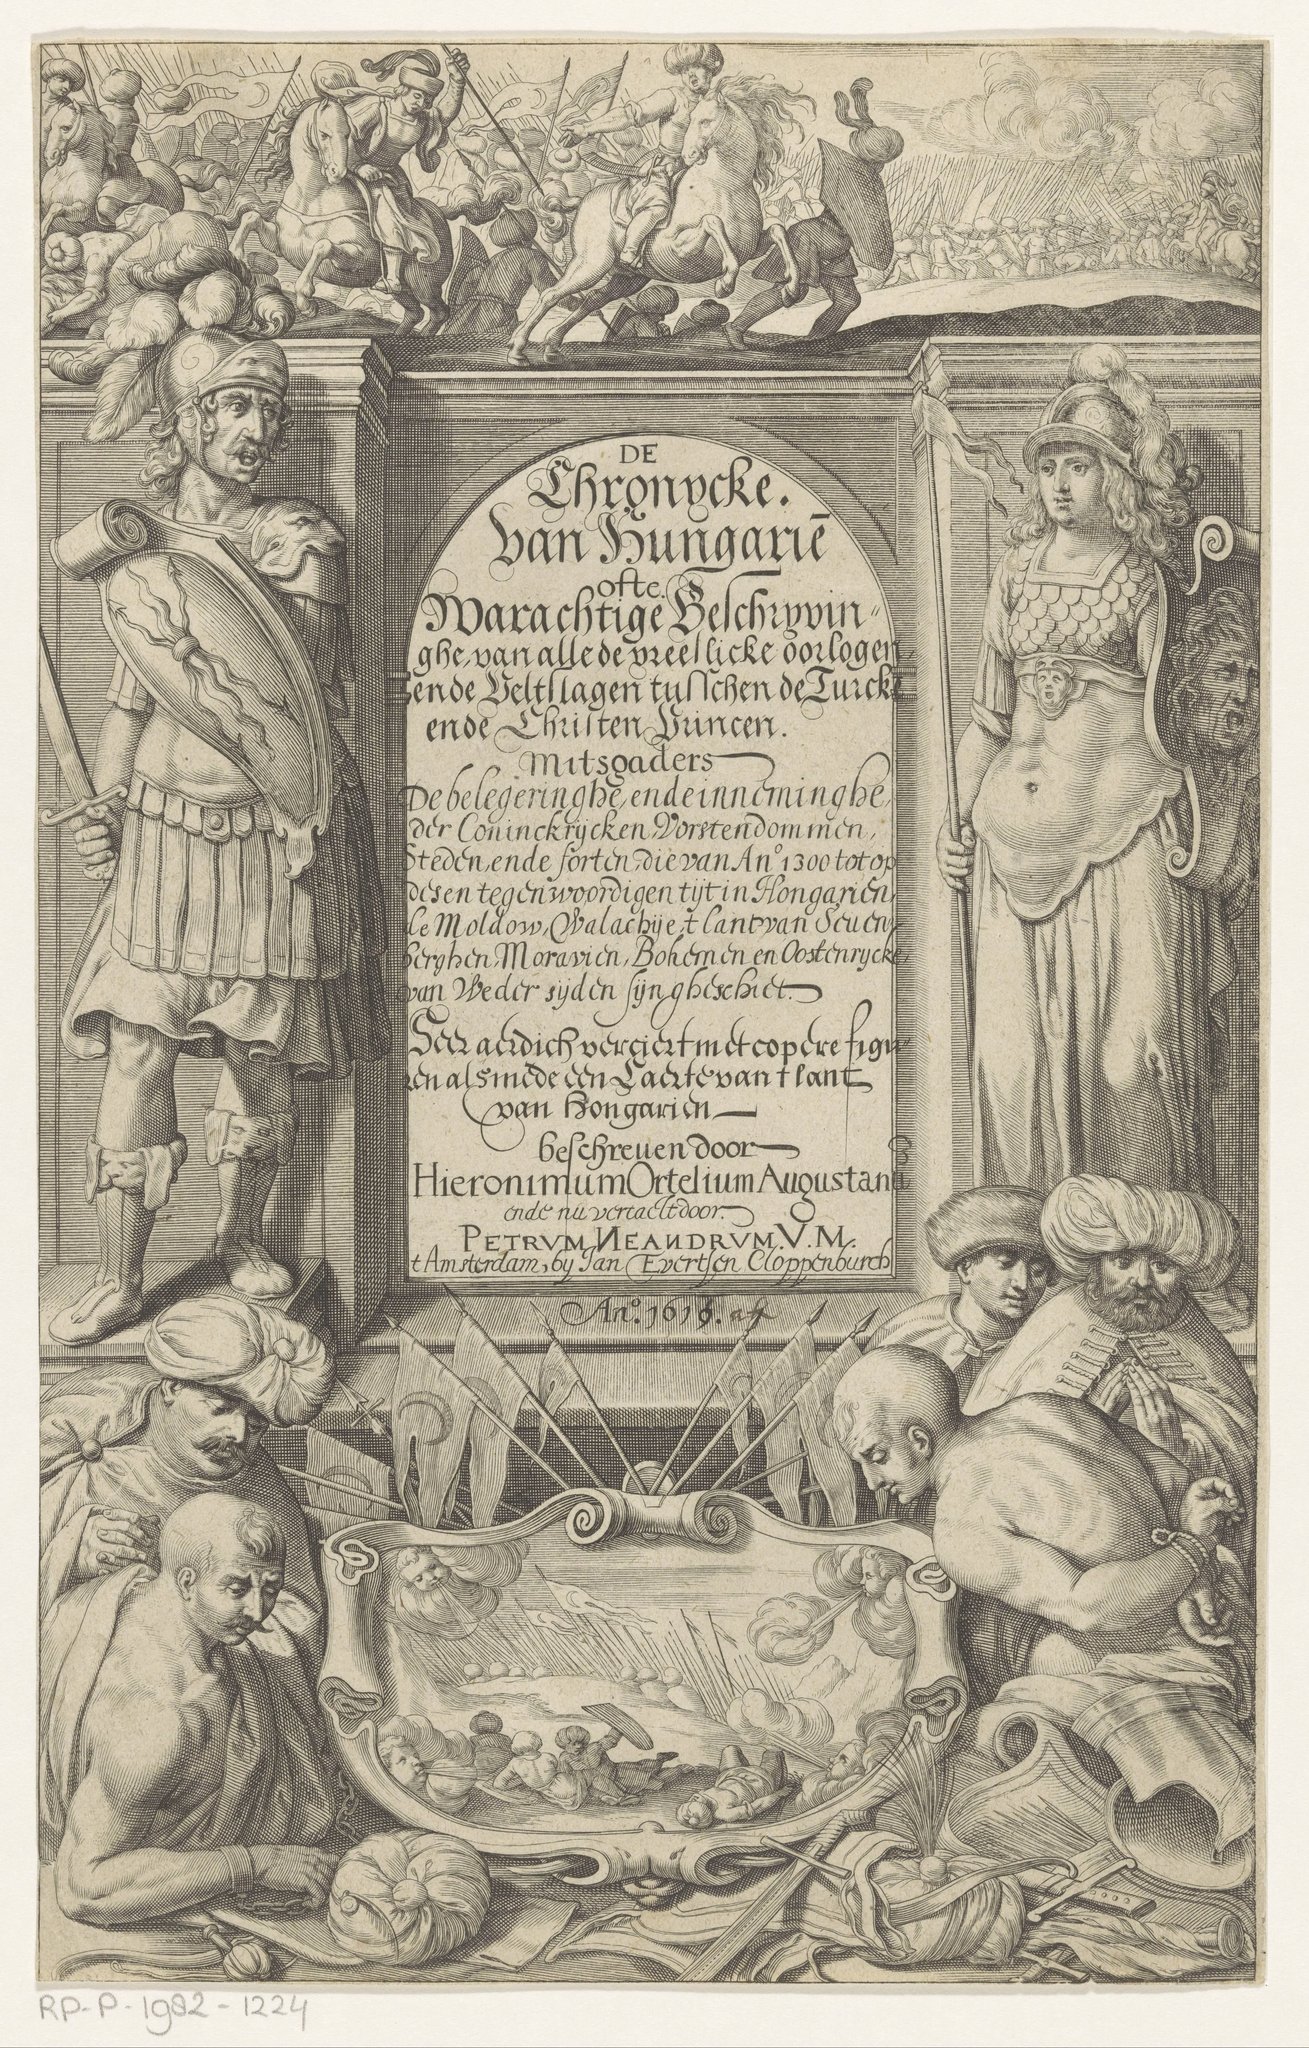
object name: print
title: Minerva en man in harnas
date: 1619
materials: paper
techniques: engraving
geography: amsterdam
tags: protective weapons: shield, (story of) minerva (pallas, athena), armour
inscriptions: collector's mark: Lugt 2228, collector's mark: Lugt 2760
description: Minerva met schild met Medusakap en een man in harnas met zwaard en schild met bliksemschichten, mogelijk Mars, flankeren de titel. Daarvoor zitten twee geketende figuren en drie mannen met tulband naast een cartouche met vlagen en een veldslag. Aan de bovenzijde een veldslag met ruiters te paard.